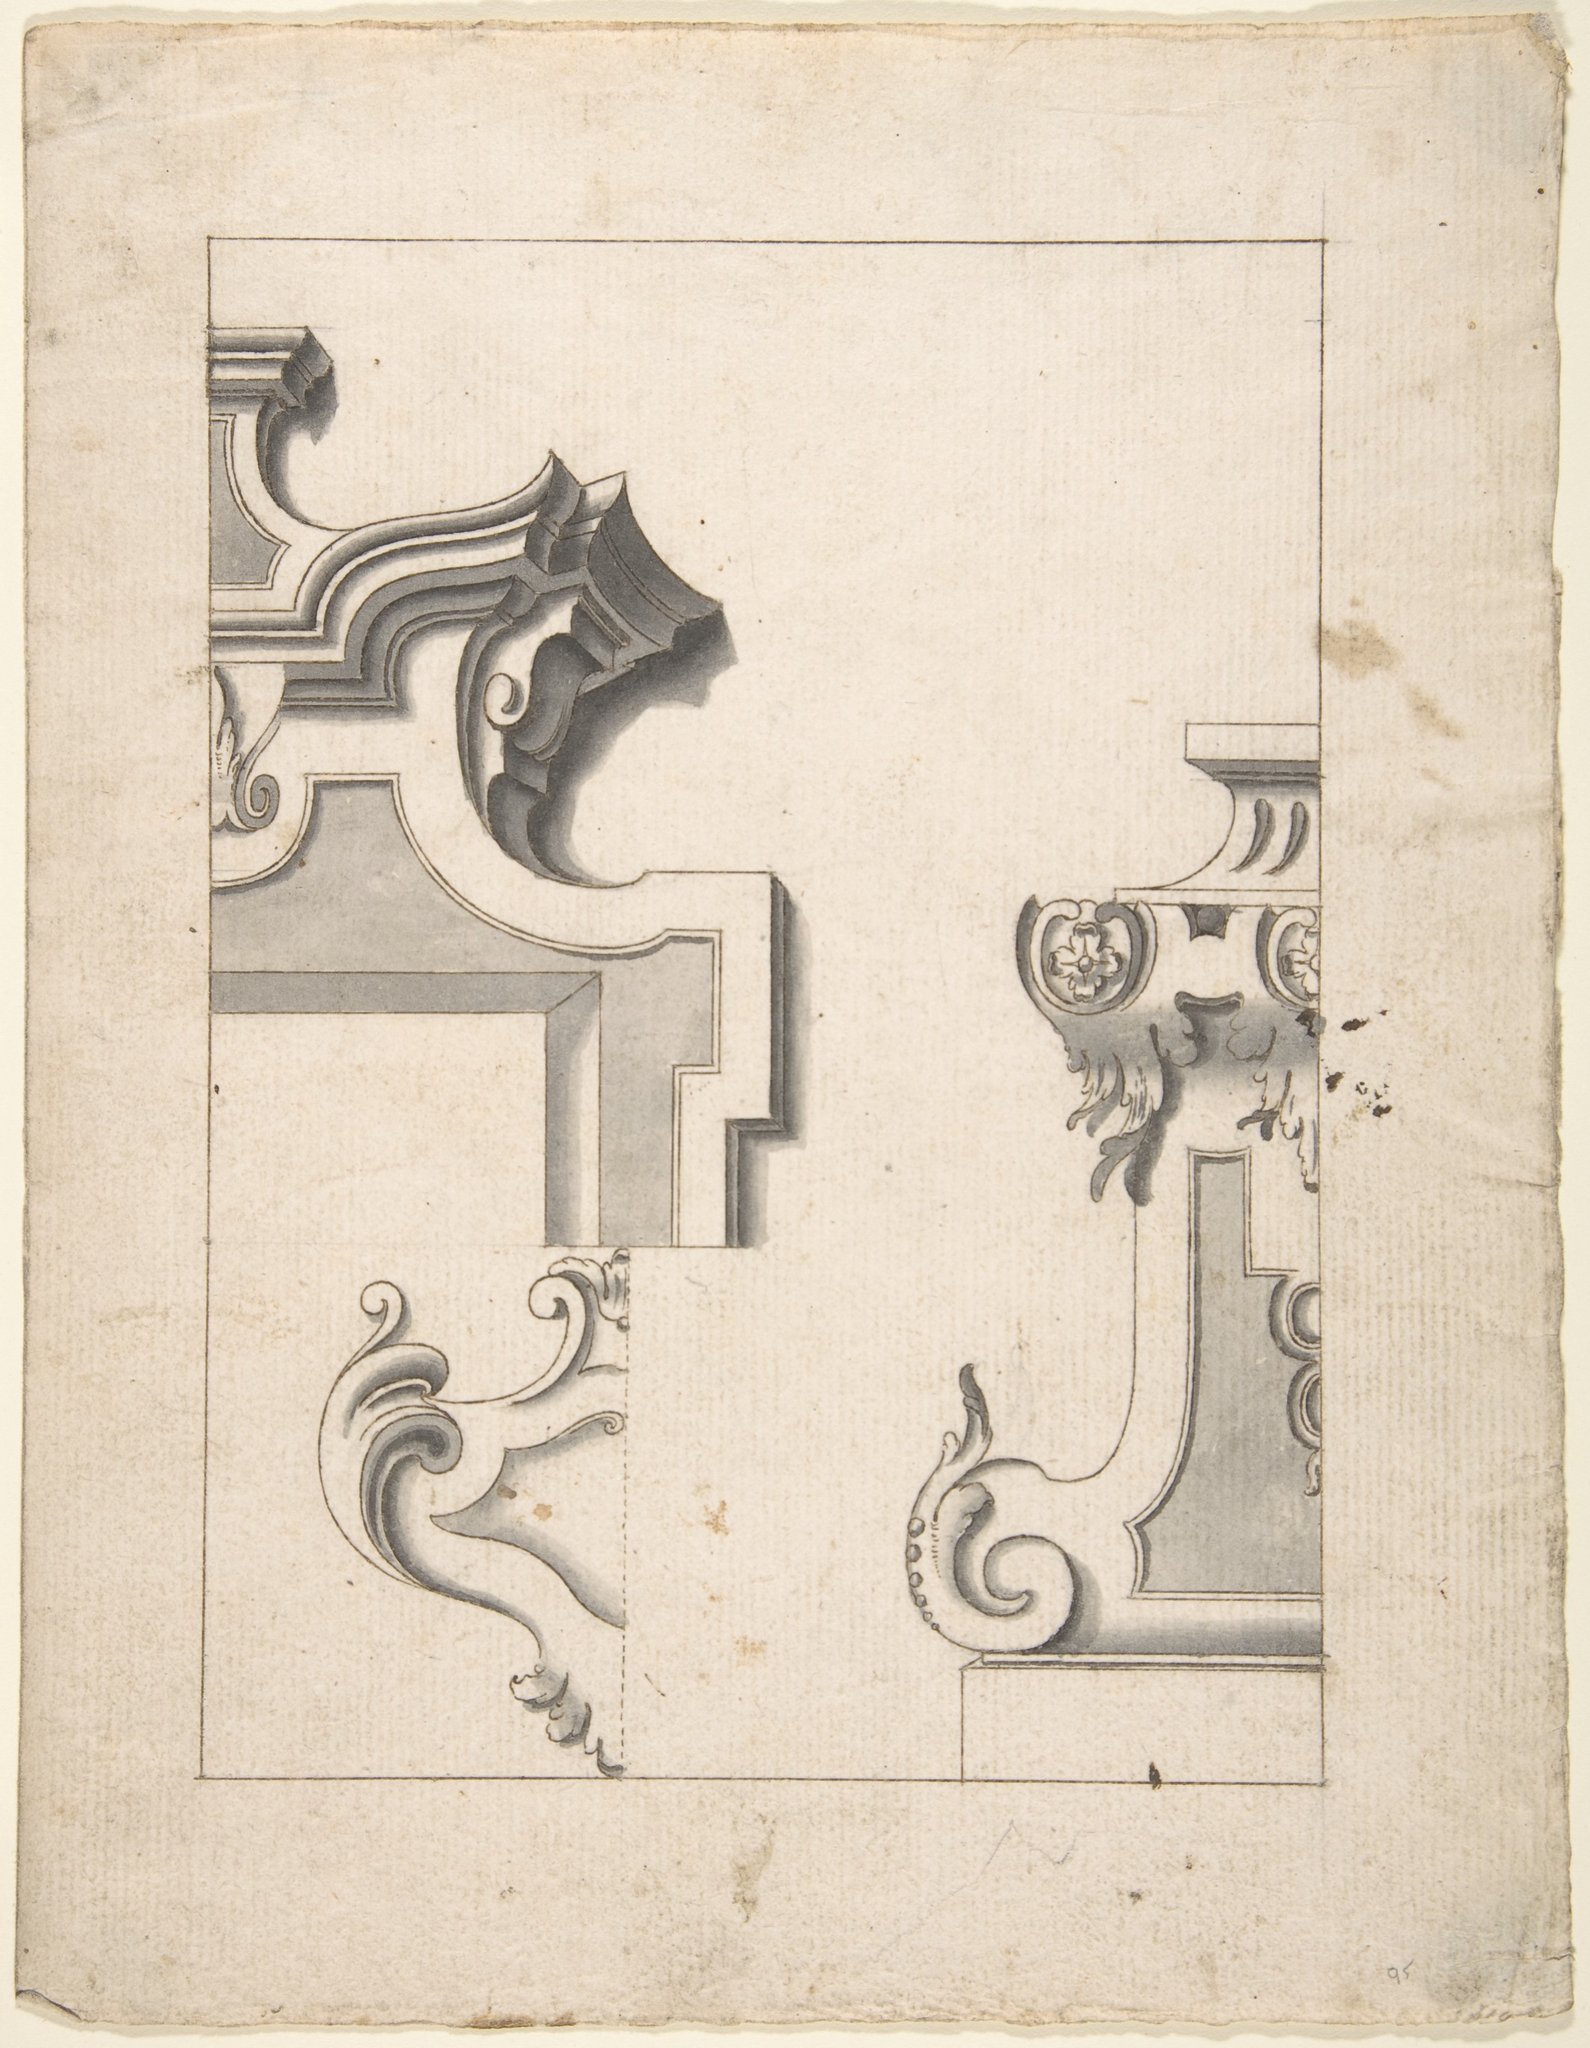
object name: drawing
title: Designs for One Half of an Overdoor, and One Half of a Pedestal (?)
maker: anonymous, italian, piedmontese, 18th century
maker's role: artist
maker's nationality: italian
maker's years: 1700-1800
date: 1700-1780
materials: graphite, ink, drawing material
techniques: brush, pen, wash